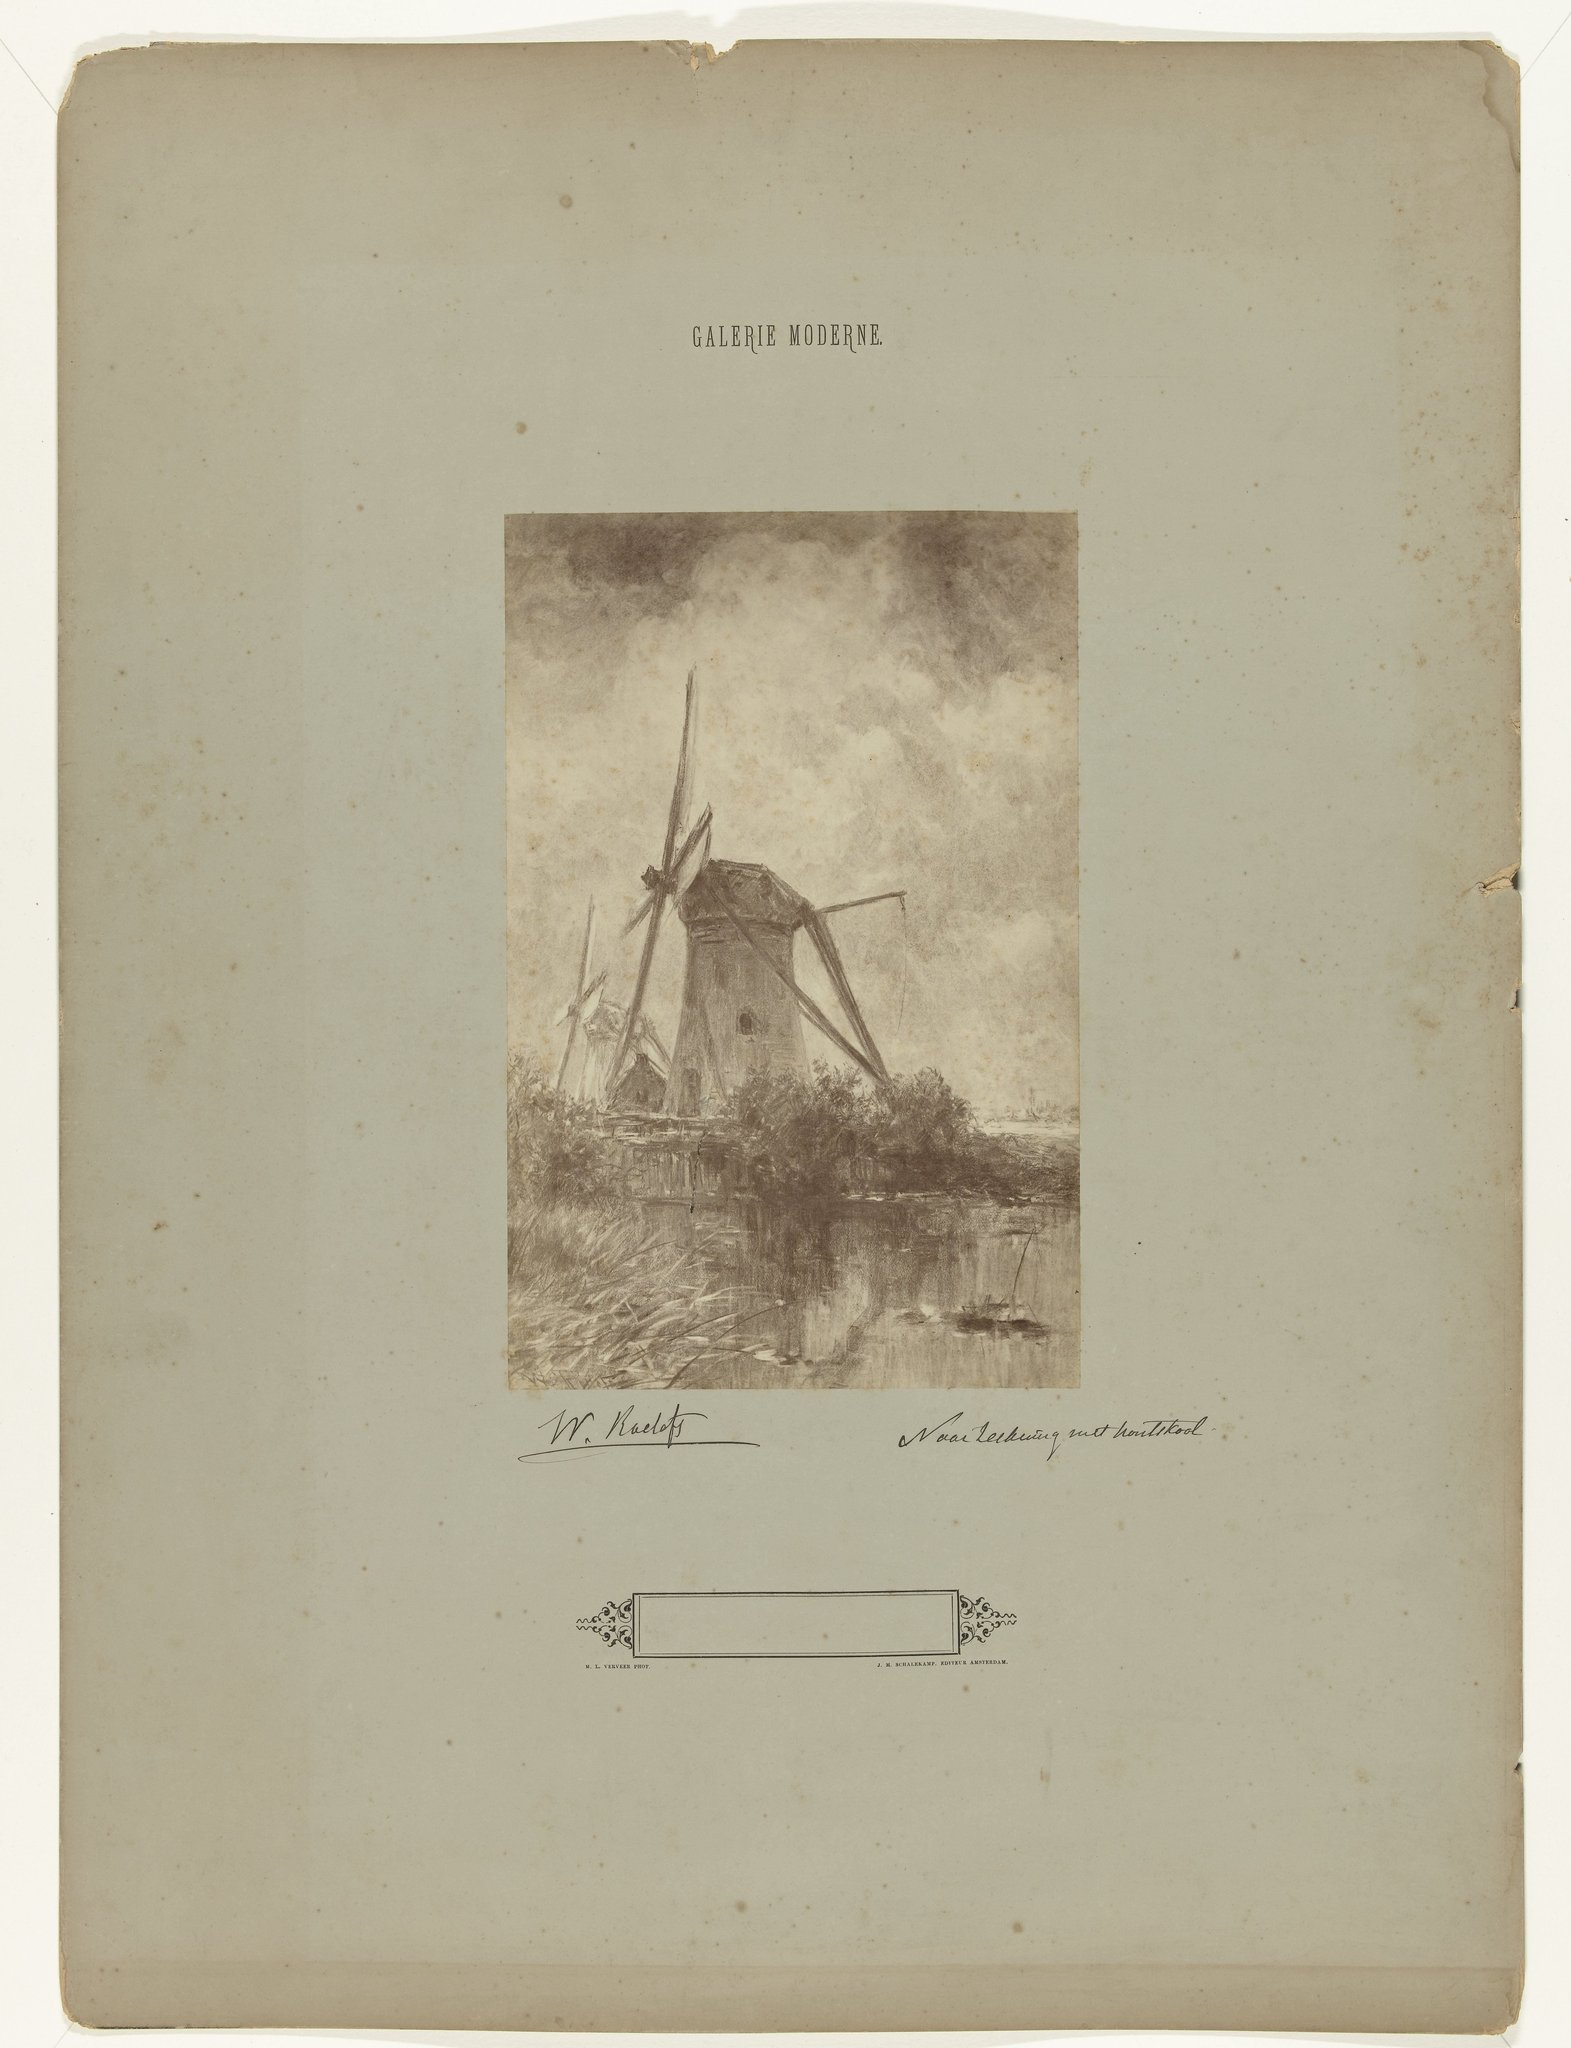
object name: photograph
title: Galerie Moderne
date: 1875-1890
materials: cardboard, photographic support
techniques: albumen print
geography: amsterdam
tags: picture, painting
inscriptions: inscription: ‘Naar teekening met houtskool’